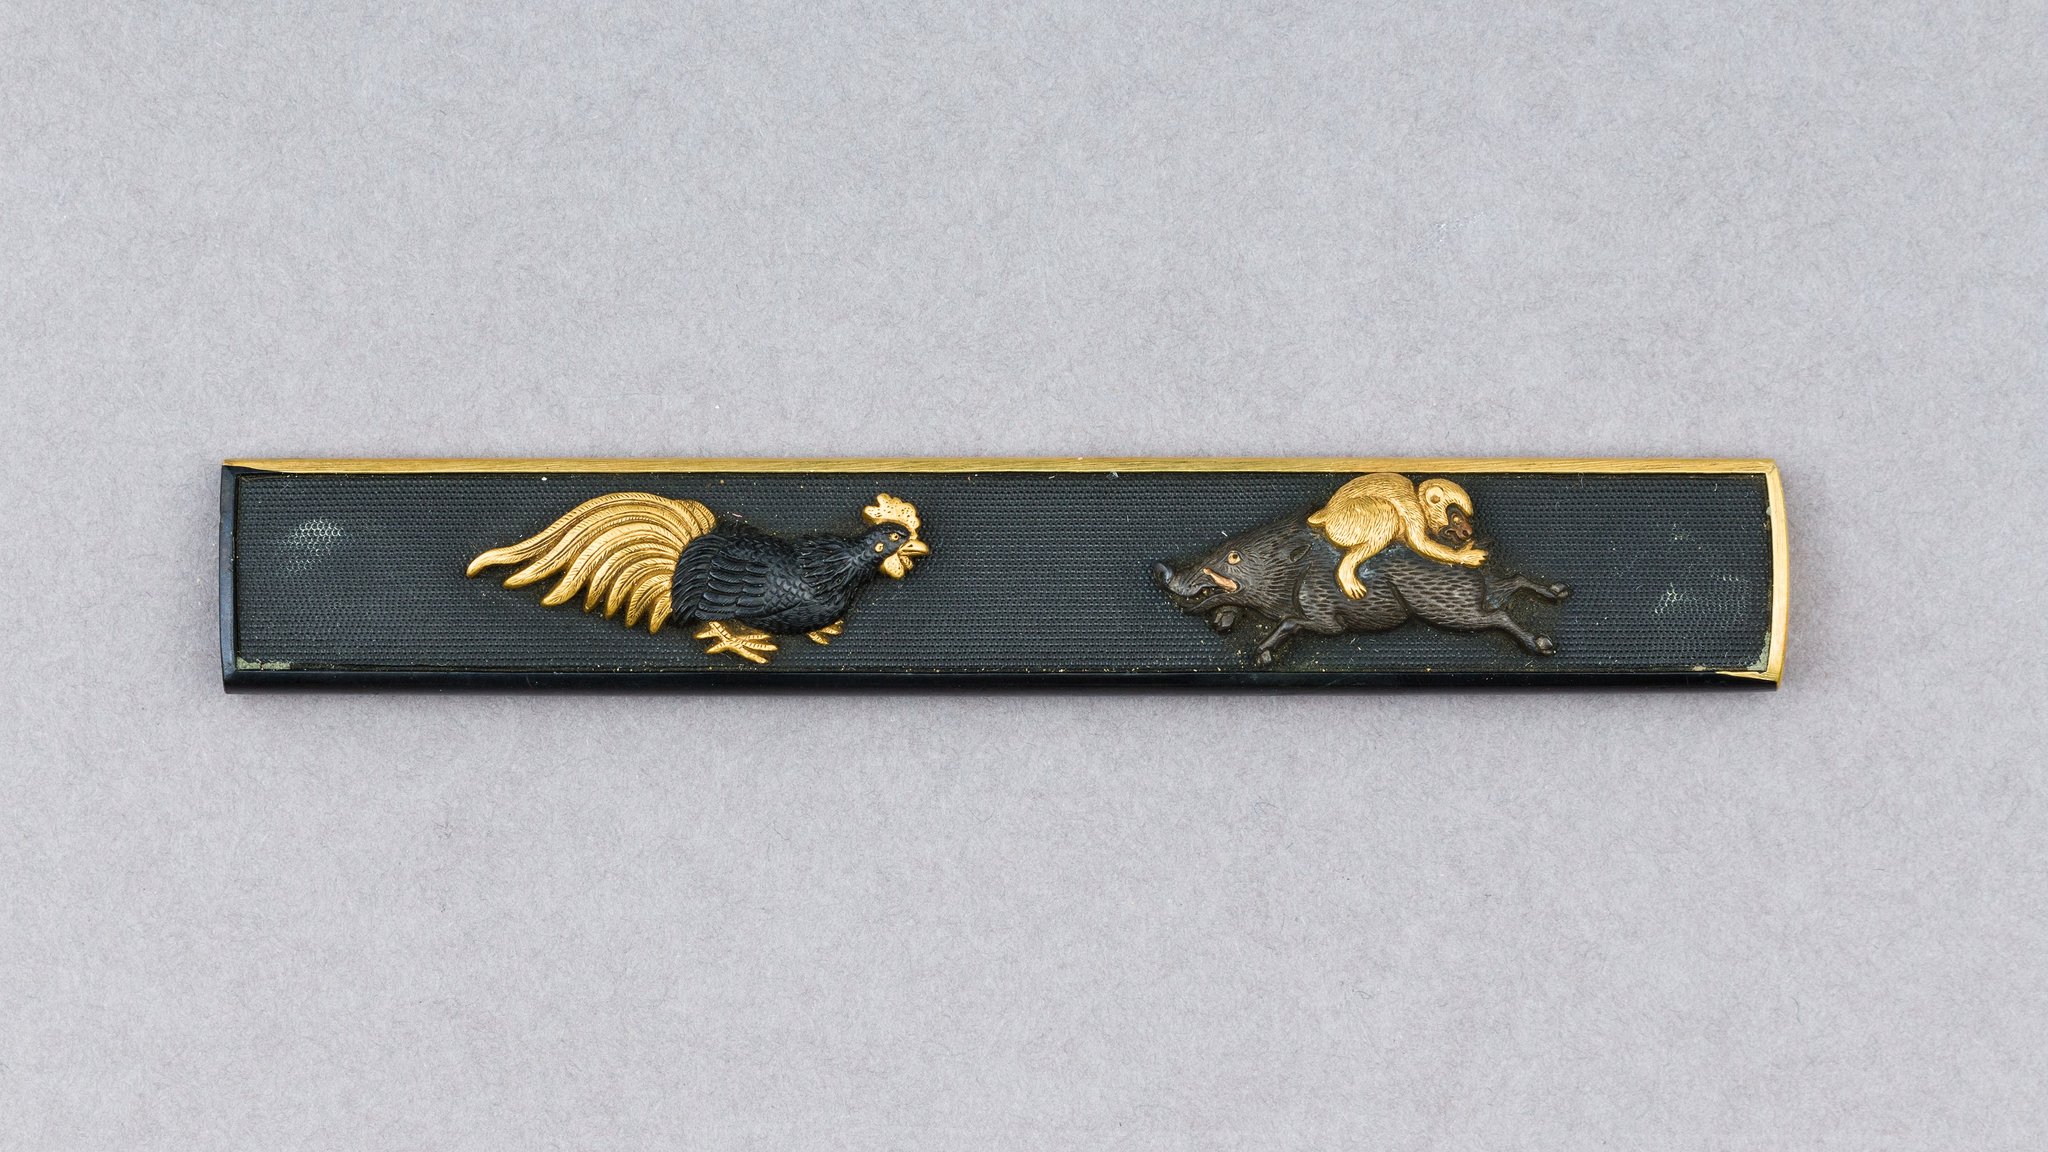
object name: knife handle kozuka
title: Knife Handle (Kozuka)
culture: japanese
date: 1615-1868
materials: gold alloy, silver alloy, gold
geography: japan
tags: roosters,boars,monkeys